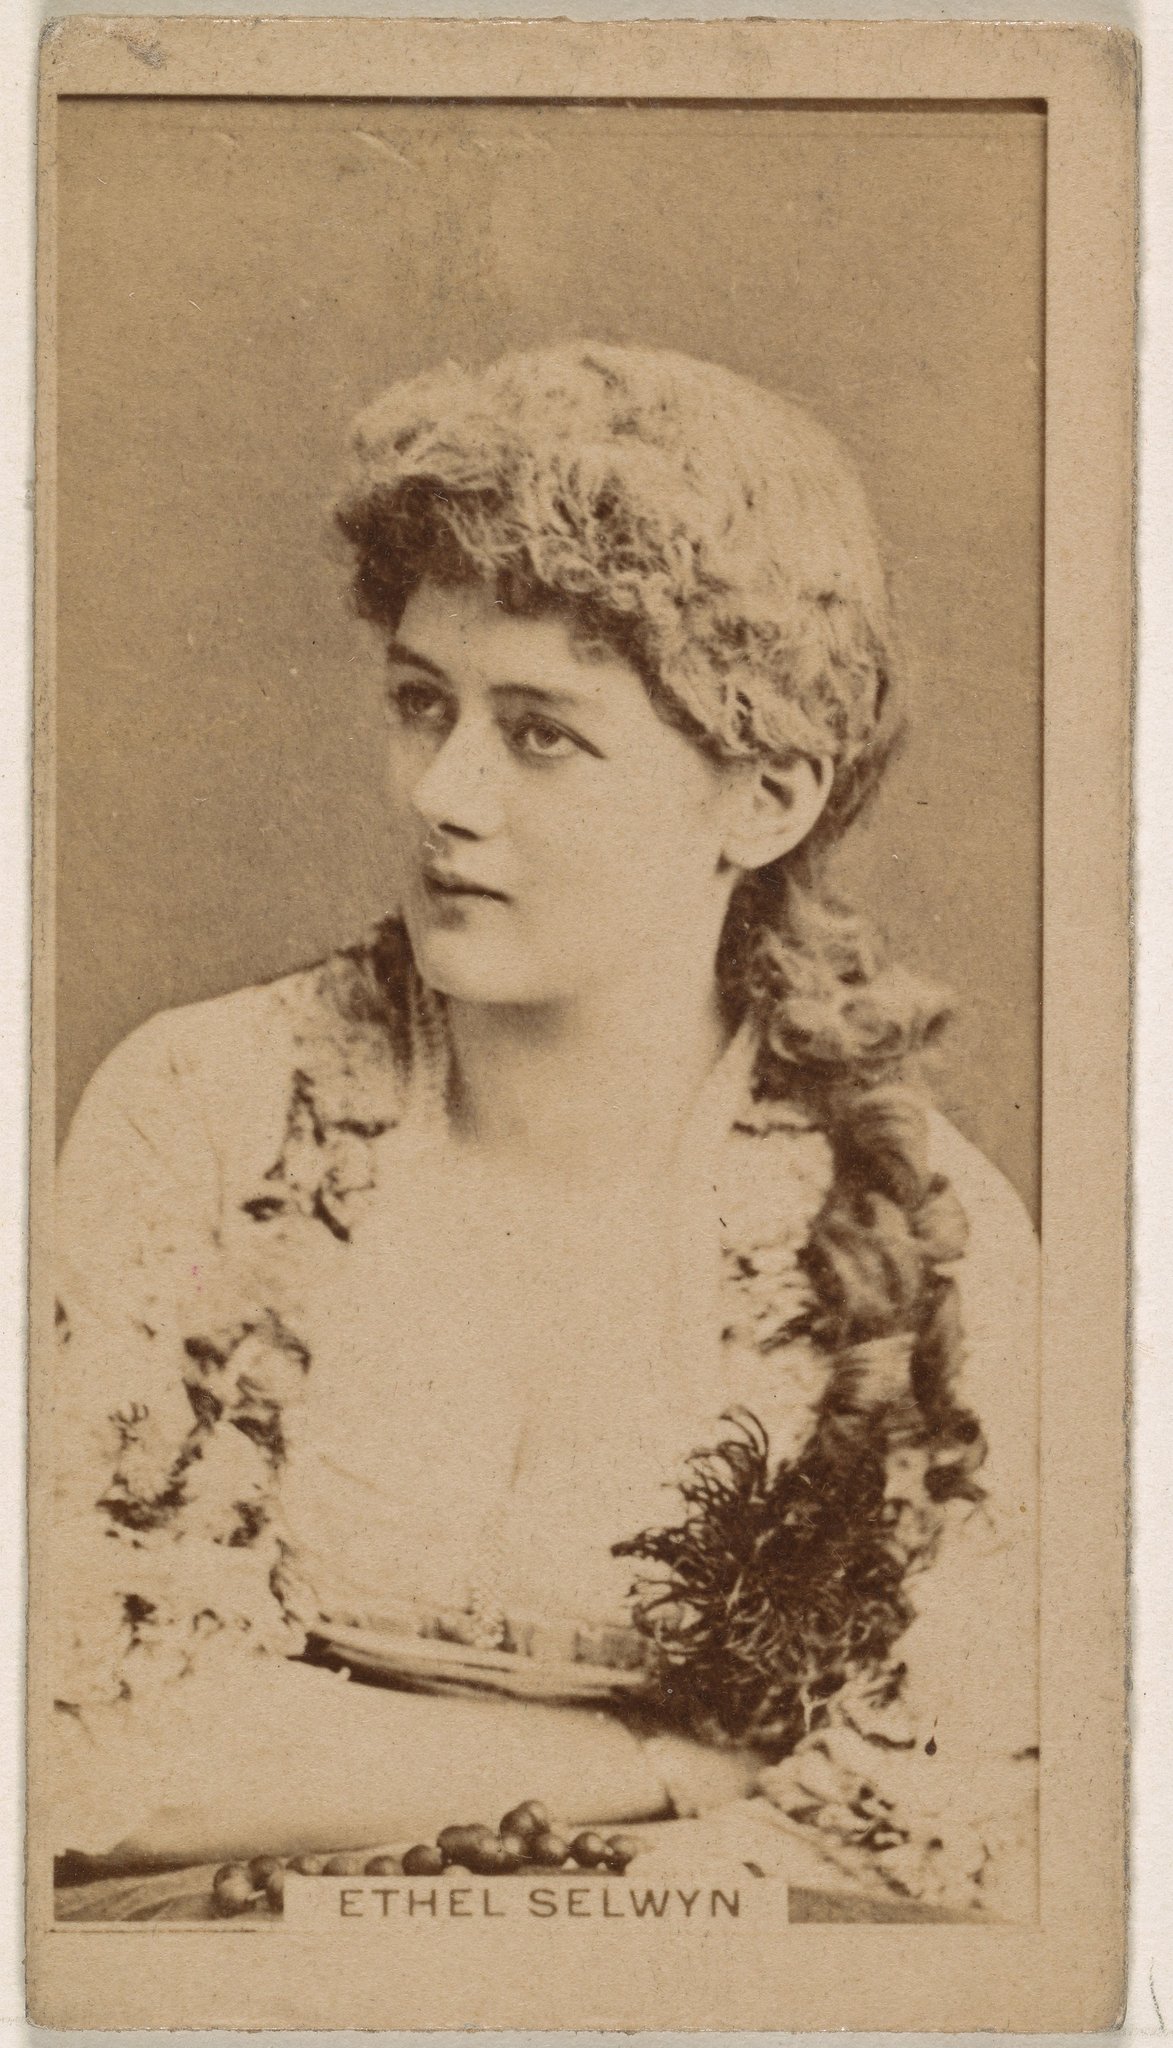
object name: photograph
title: Ethel Selwyn, from the Actresses series (N245) issued by Kinney Brothers to promote Sweet Caporal Cigarettes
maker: kinney brothers tobacco company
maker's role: publisher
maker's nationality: american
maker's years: 1869-2011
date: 1890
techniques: albumen silver print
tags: portraits,women,actresses